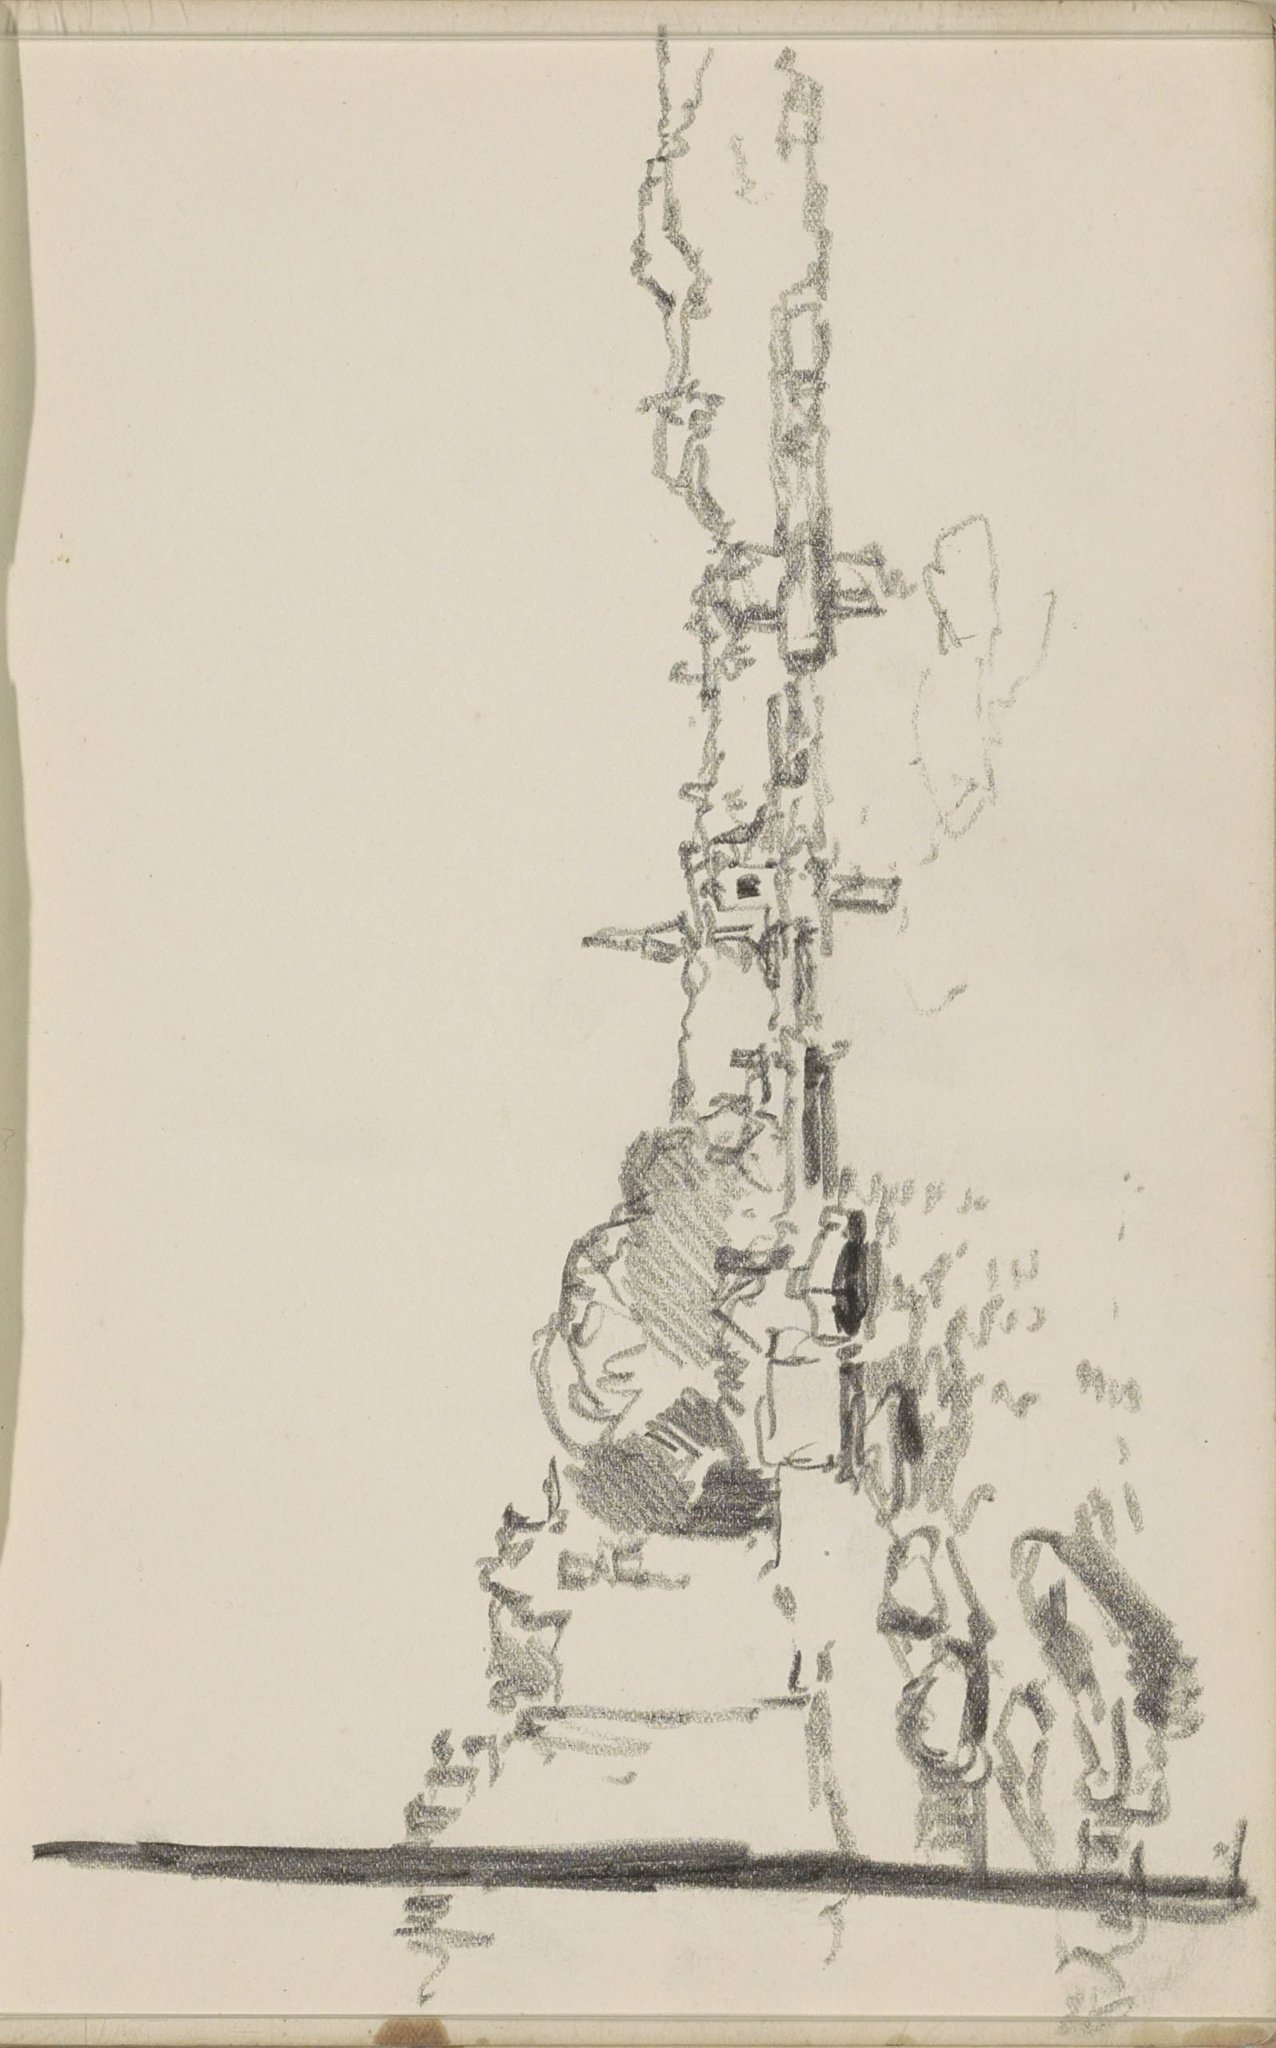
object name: sketchbook leaf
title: Gezicht op een stad aan het water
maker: cornelis vreedenburgh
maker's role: draughtsman, print maker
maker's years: 1880-1946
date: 1890-1946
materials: chalk, paper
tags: city-view, and landscape with man-made constructions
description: Blad 5 recto uit een schetsboek met 45 bladen.